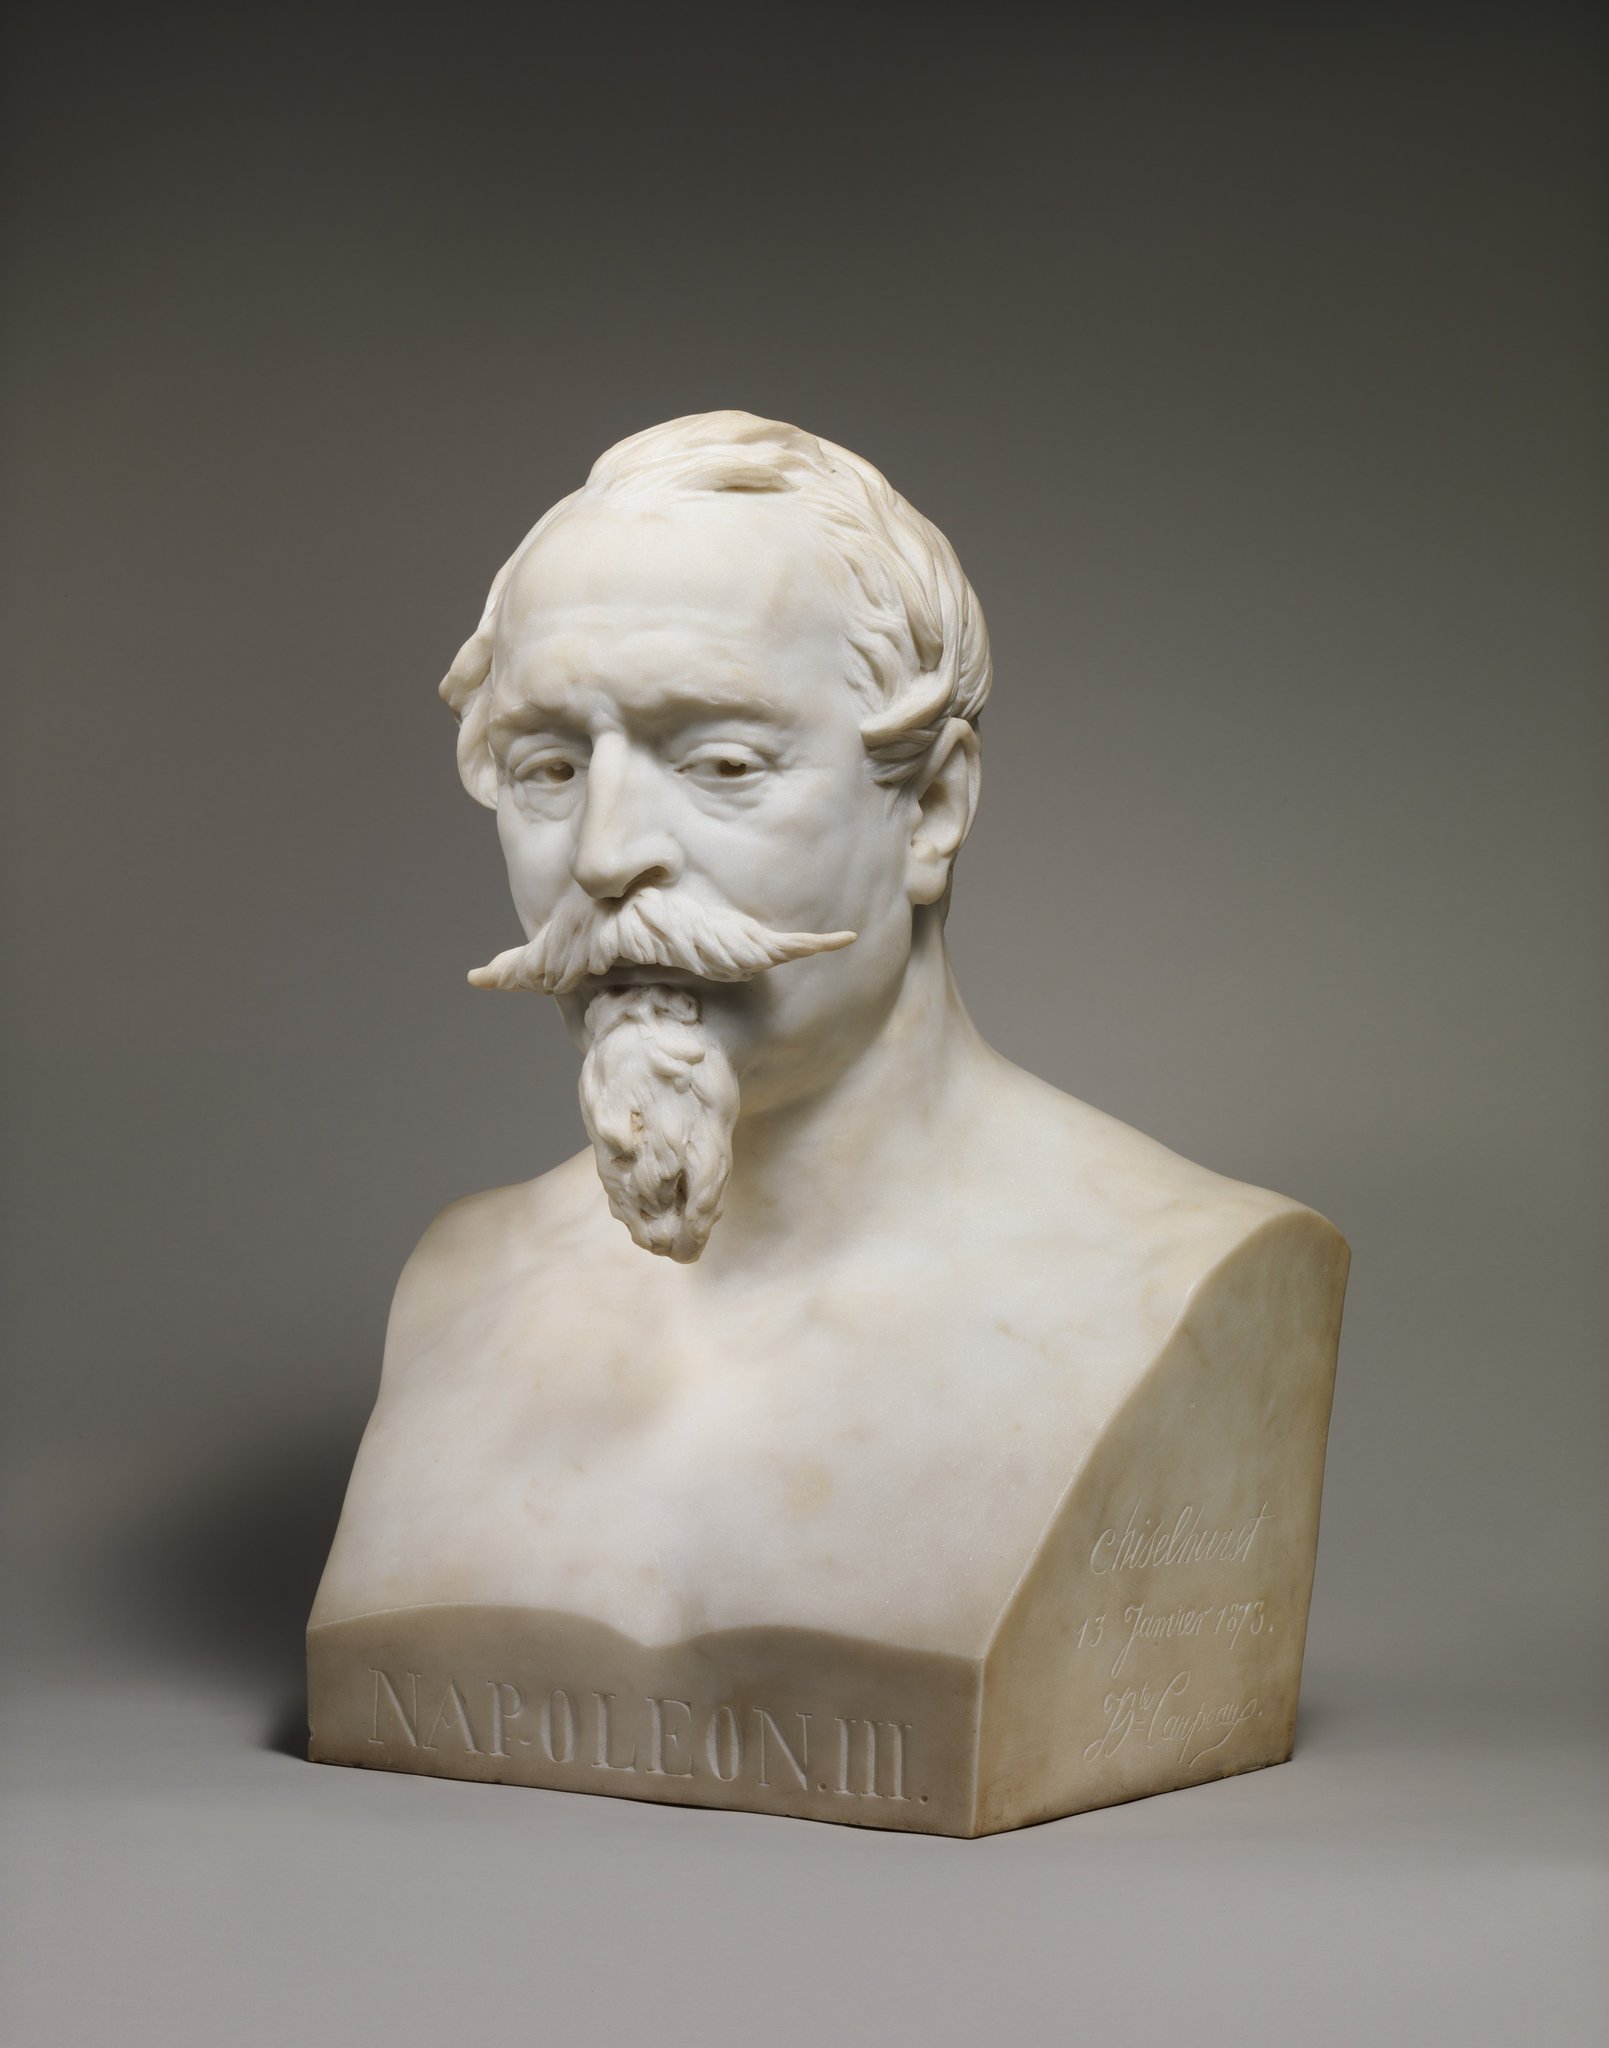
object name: bust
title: Napoléon III (1808–1873), Emperor of the French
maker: jean-baptiste carpeaux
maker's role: artist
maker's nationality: french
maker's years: 1827-1875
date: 1873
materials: marble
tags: napoleon iii,men,portraits